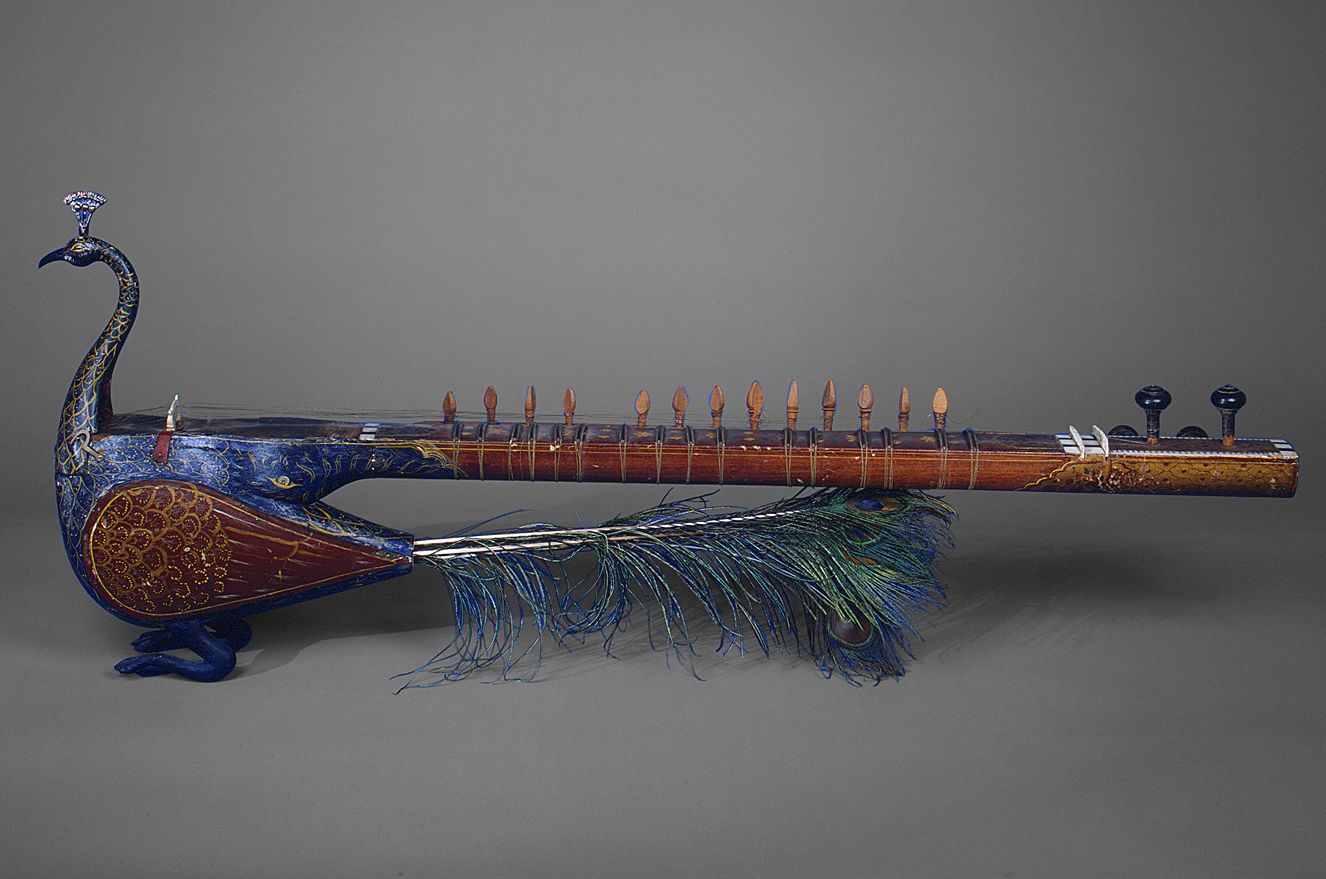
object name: taūs mayuri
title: Taūs (mayuri)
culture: indian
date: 1801-1900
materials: feather, metal, parchment, wood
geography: india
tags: peacocks